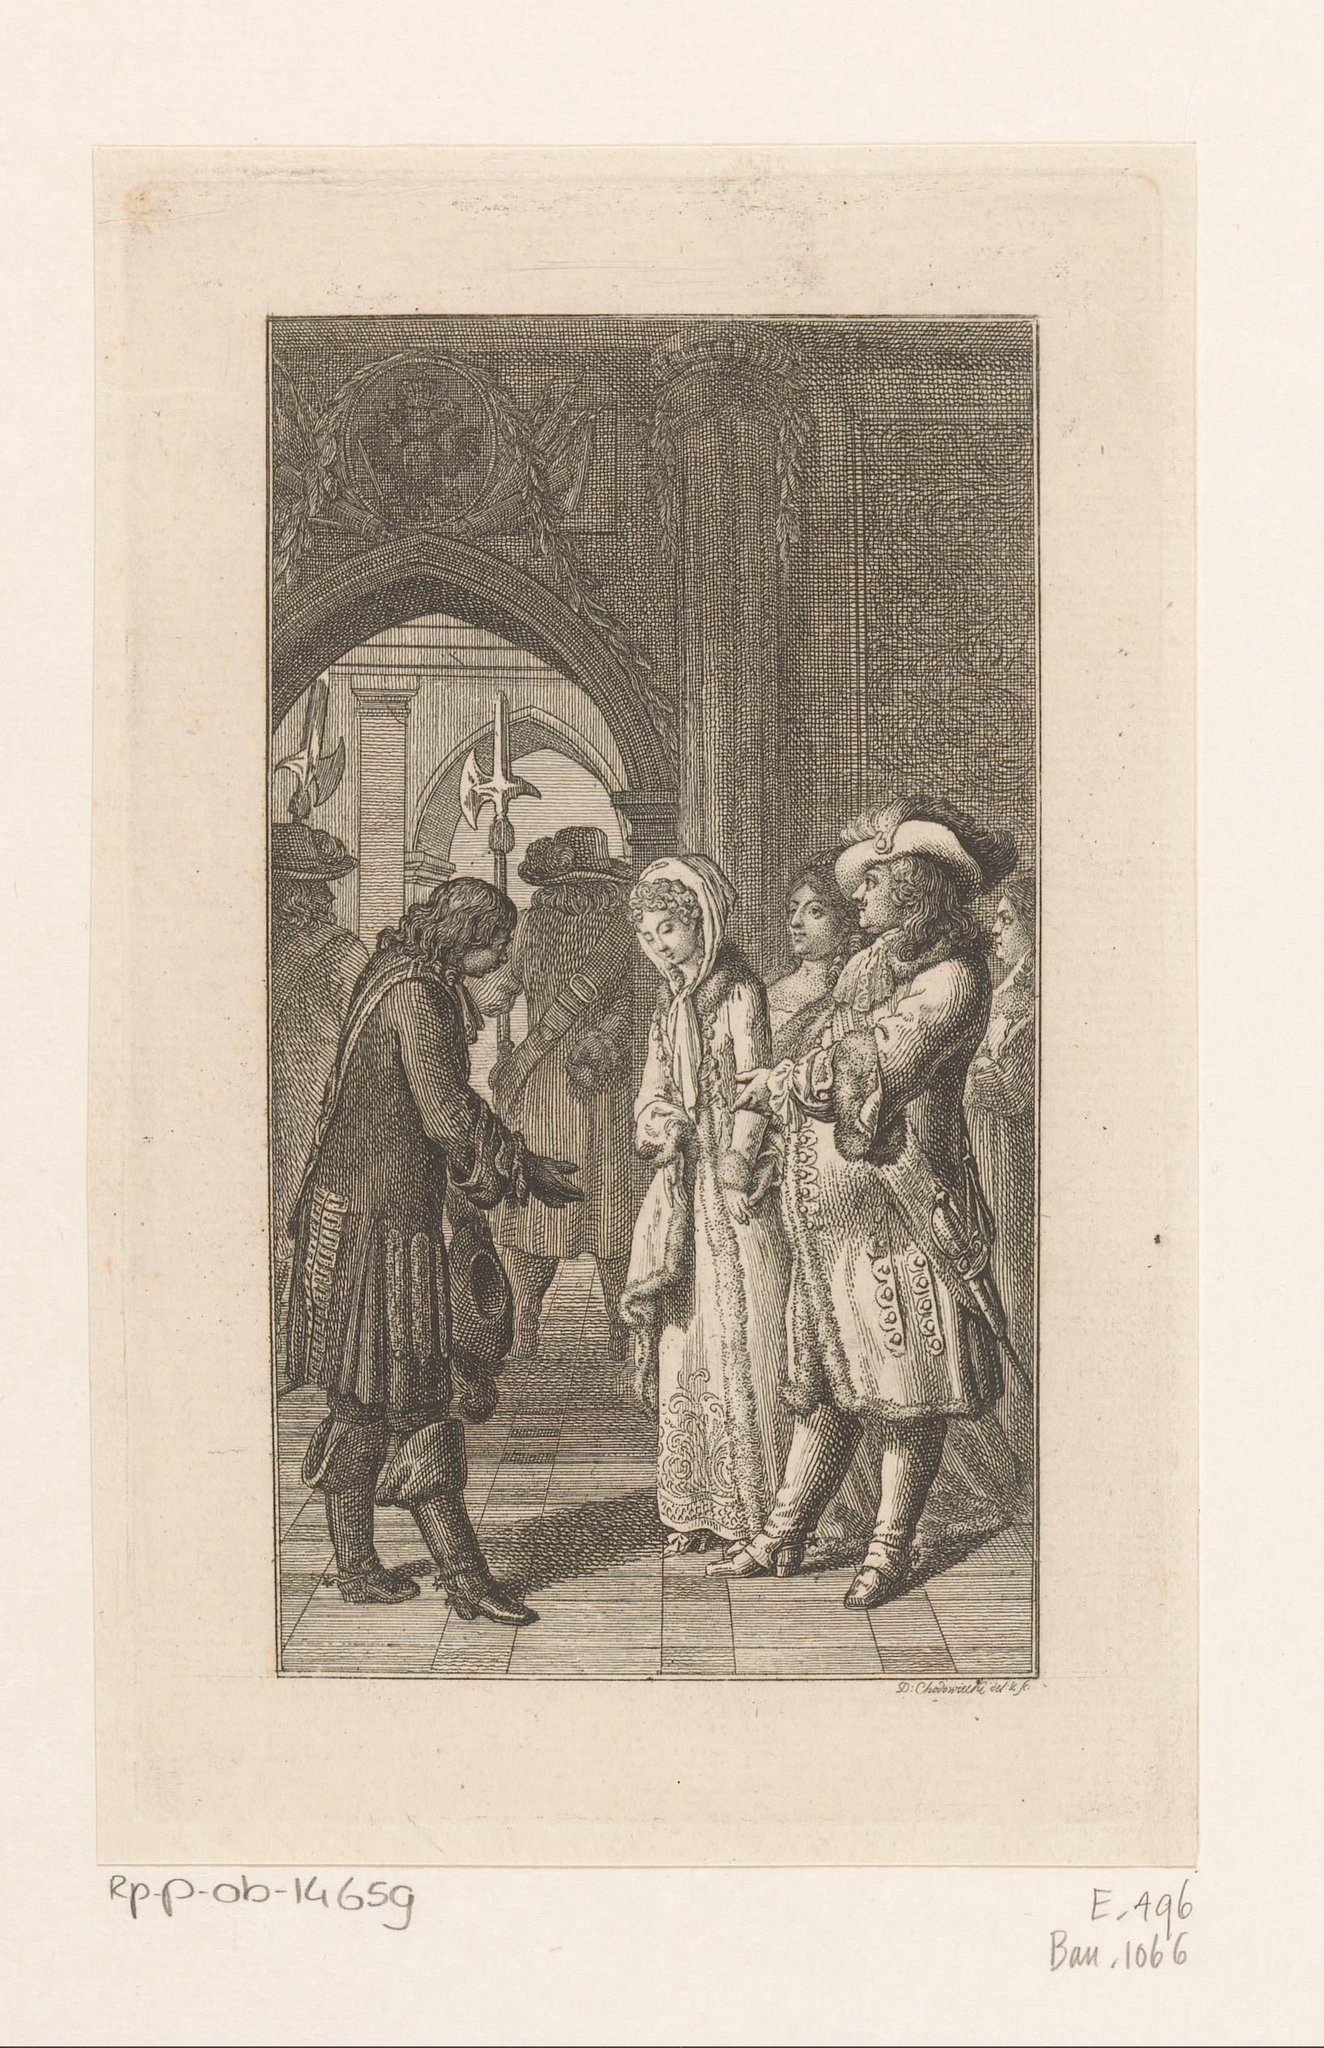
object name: print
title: Peter de Grote en het deugdzame meisje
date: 1784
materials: paper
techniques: etching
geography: leipzig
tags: peter i de grote (tsaar van rusland), double-headed eagle, adolescent, young woman, maiden, literature, emperor, interior of the house, ornament ~ festoon, garland, armorial bearing, heraldry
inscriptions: collector's mark: Lugt 2228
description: Prent uit: Weisse, Christian Felix. Briefwechsel der Familie des Kinderfreundes. Leipzig: bei Siegfried Lebrecht Crusius, 1784.